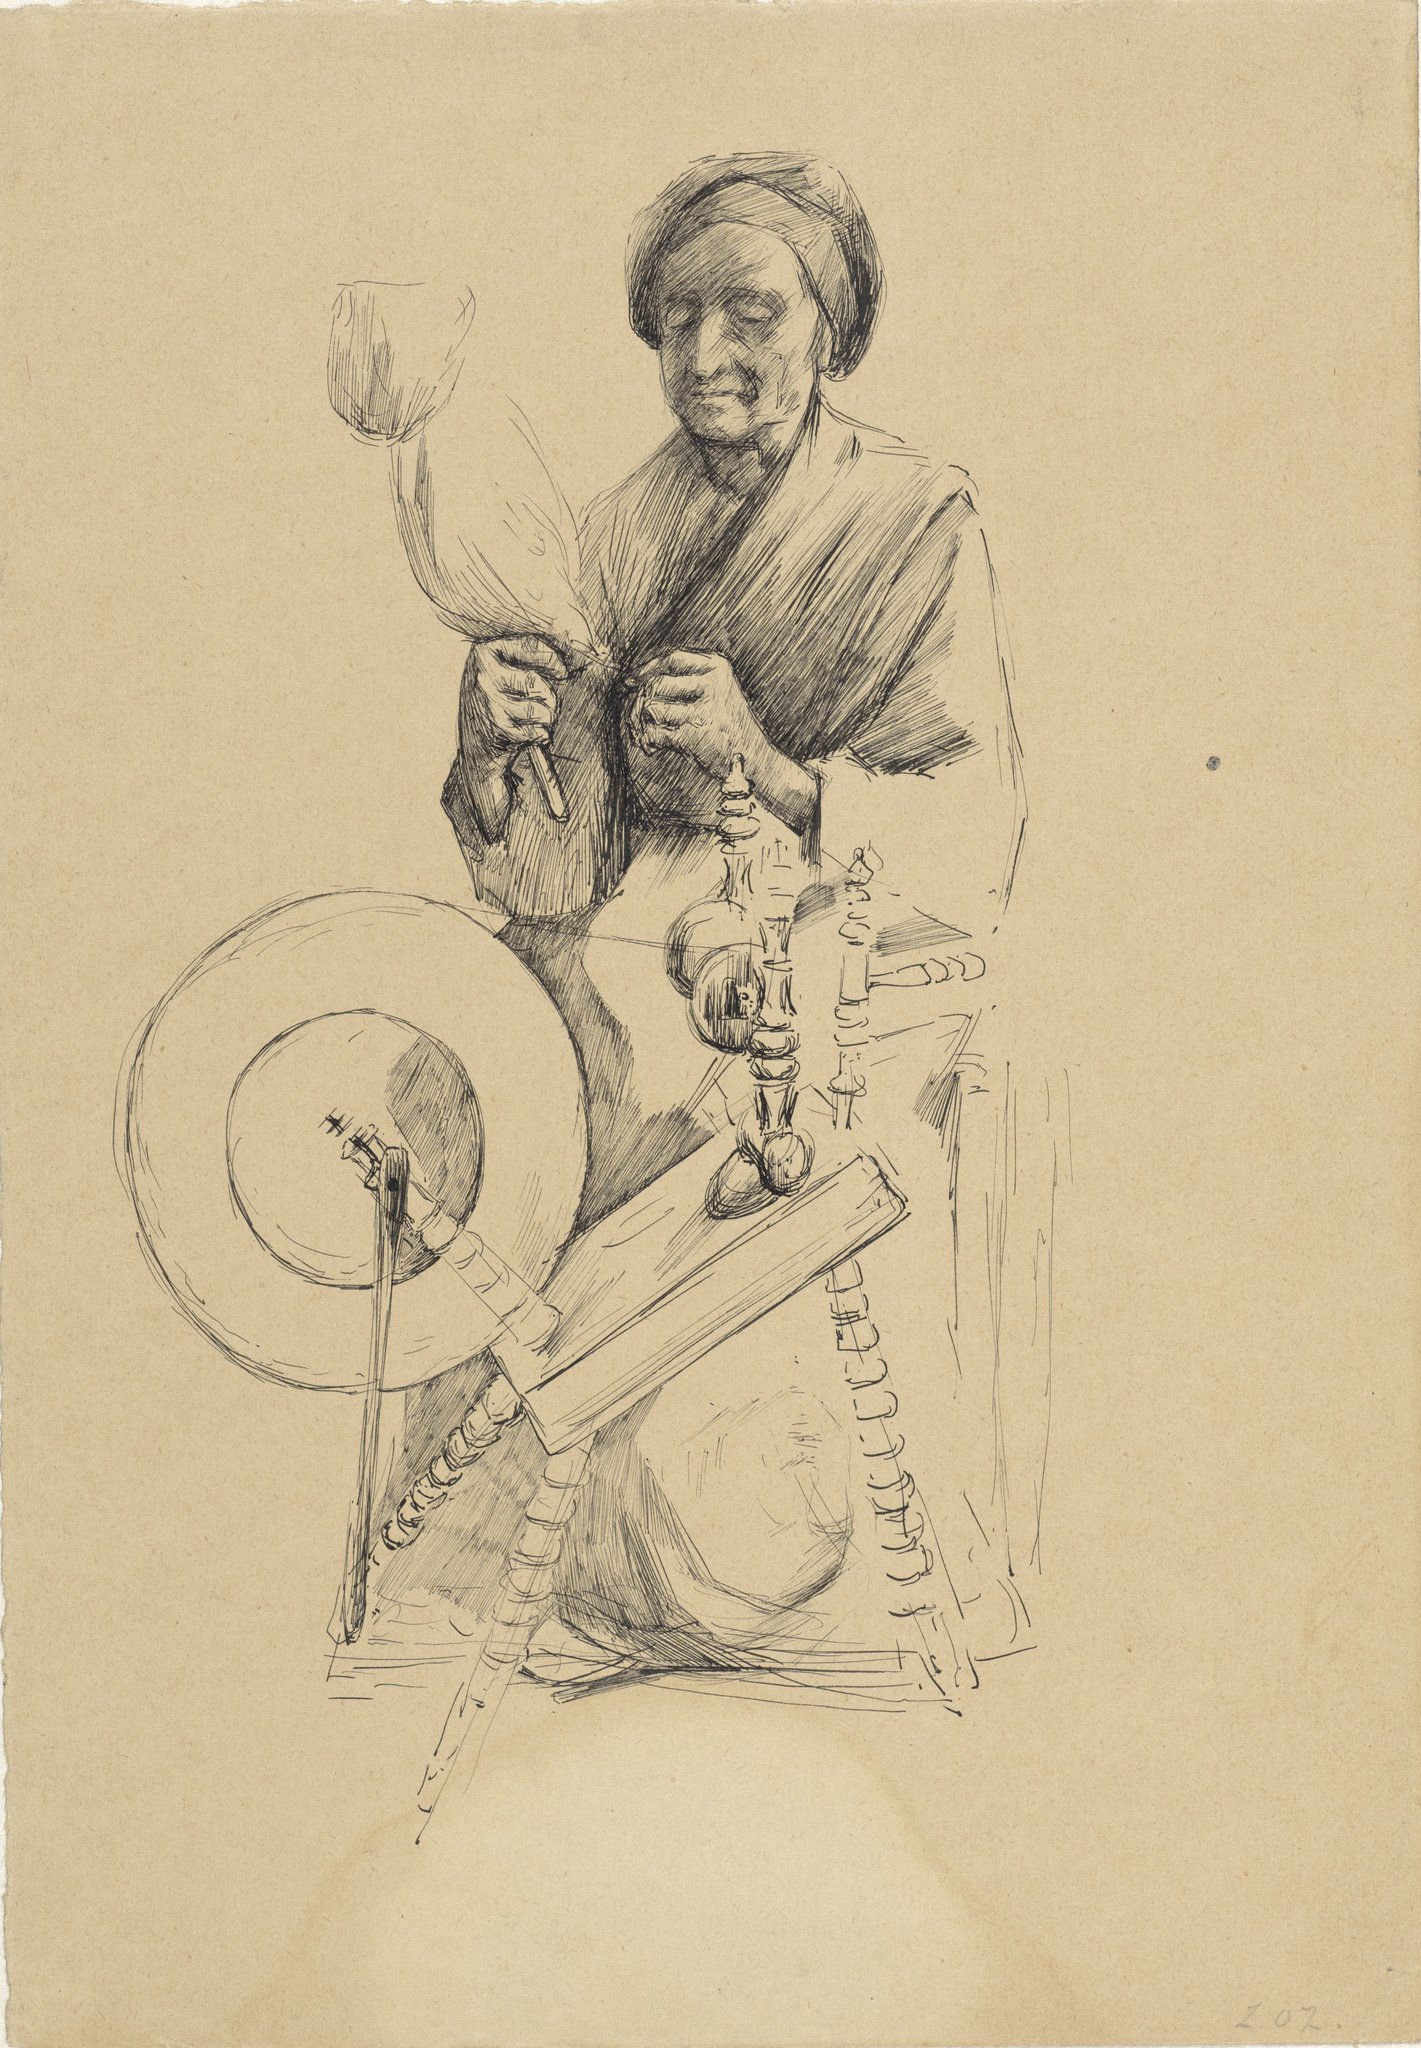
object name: drawing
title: Spinnende vrouw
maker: anthon gerhard alexander van rappard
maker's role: draughtsman, print maker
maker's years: 1858-1892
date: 1868-1892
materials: ink, paper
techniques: pen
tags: spinning-wheel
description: Spinnende vrouw. Op verso een man met pet en voorschoot.